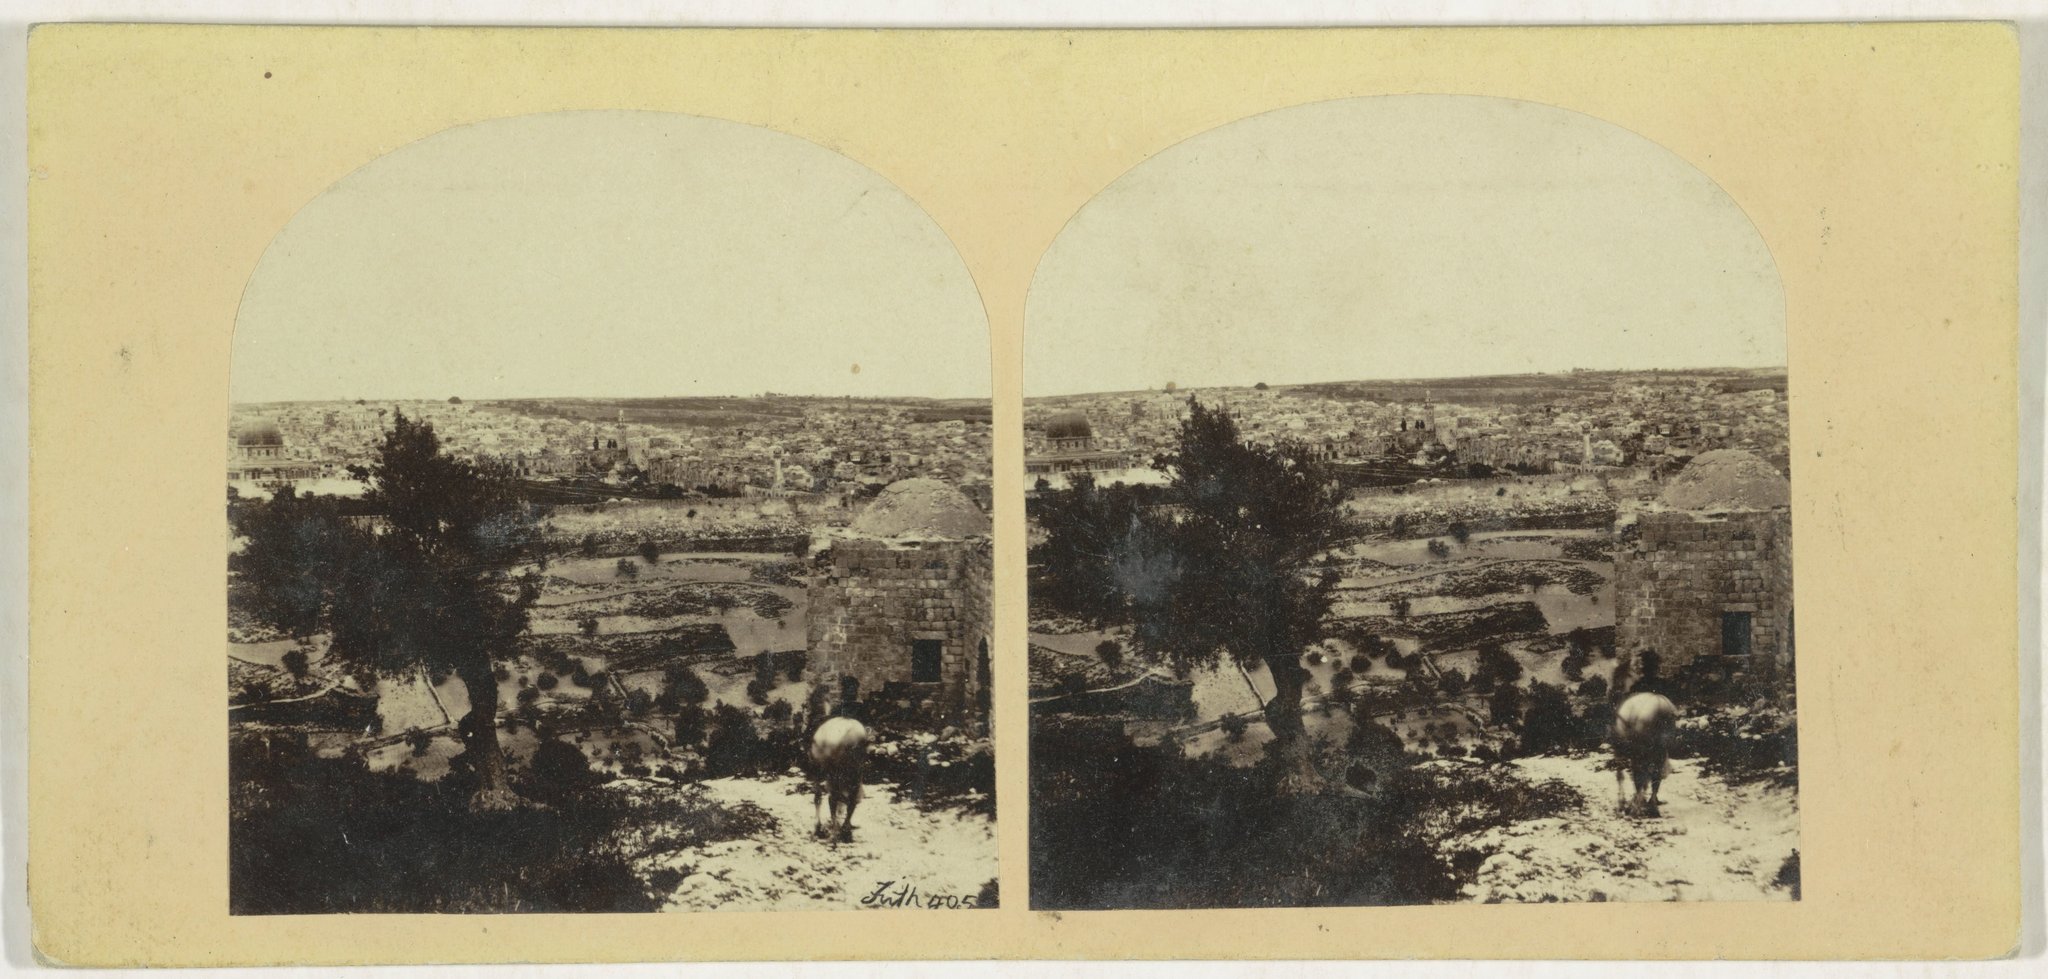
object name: stereograph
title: Views in the Holy Land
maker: francis frith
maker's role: publisher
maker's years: 1822-1898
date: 1859-1861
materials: cardboard, paper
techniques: albumen print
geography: olijfberg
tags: city-view in general; 'veduta'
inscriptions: inscription: ‘Vue de Jerusalem du mont des olives./ [...]’, inscription: ‘This site is marked to the right foreground by the ruins of a convent formerly belonging to the Georgian/ Christians. The minaret seen in the centre of (...)’, inscription: ‘[Deposé.’, inscription: ‘Entered at Stationers' Hall.]’, inscription: ‘TAKEN FROM THE PATHWAY LEADING FROM GETHSEMNI TO BETHANY, LOOKING/ WEST, AND CLOSE TO THE SPOT WHERE THE SAVIOUR FORETOLD THE/ DESTRUCTION OF THE TEMPLE AND OF THE CITY.’, number: ‘405’